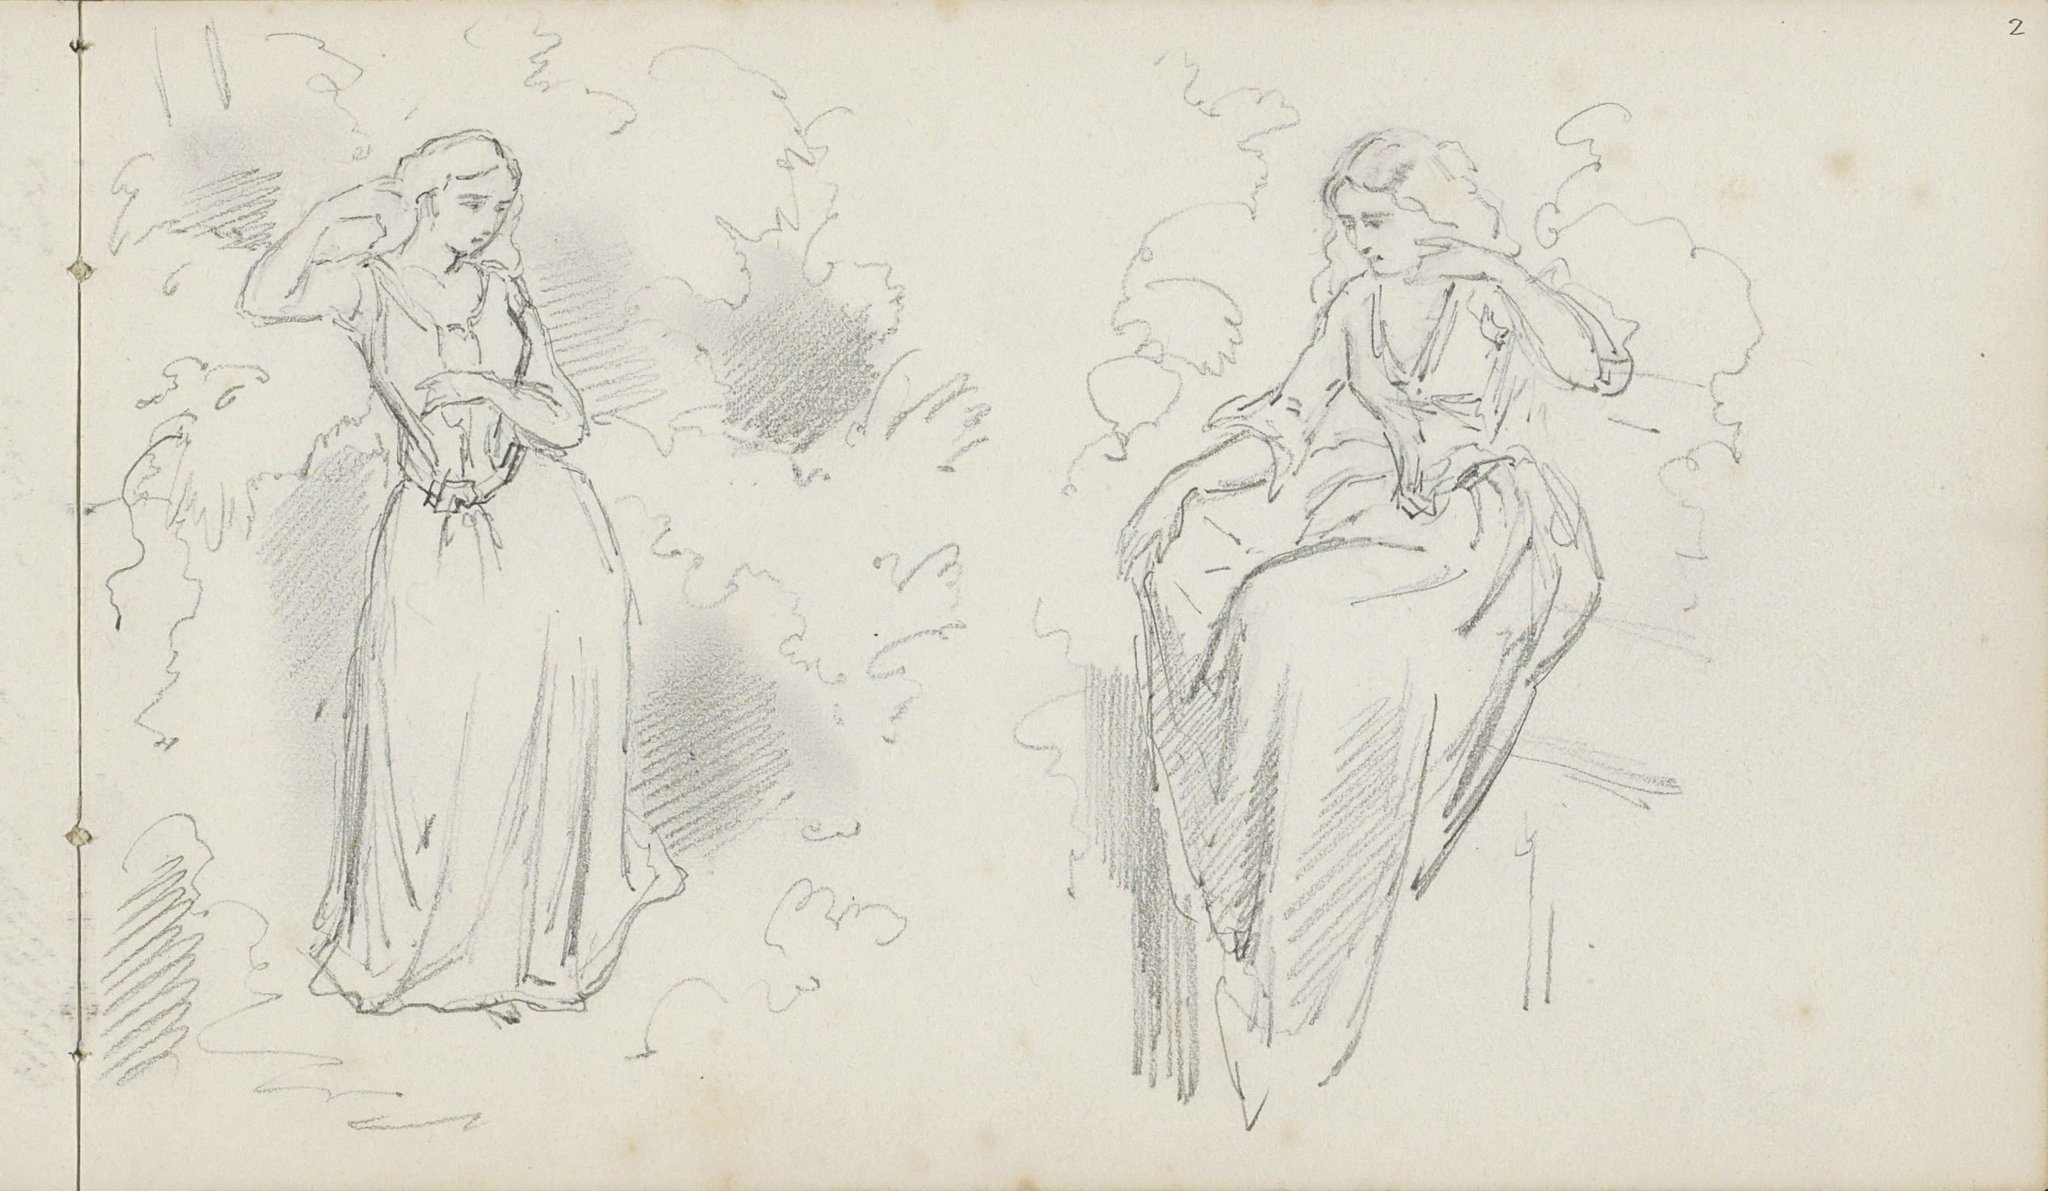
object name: sketchbook leaf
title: Staande en zittende jonge vrouw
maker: charles rochussen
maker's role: draughtsman, painter, print maker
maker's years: 1814-1894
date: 1840-1860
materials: paper, pencil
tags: shrubs, standing figure - aa - female human figure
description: De vrouw draagt een lange japon en is getekend tegen een achtergrond van bomen of struiken. Blad 2 recto uit een schetsboek met 38 bladen.